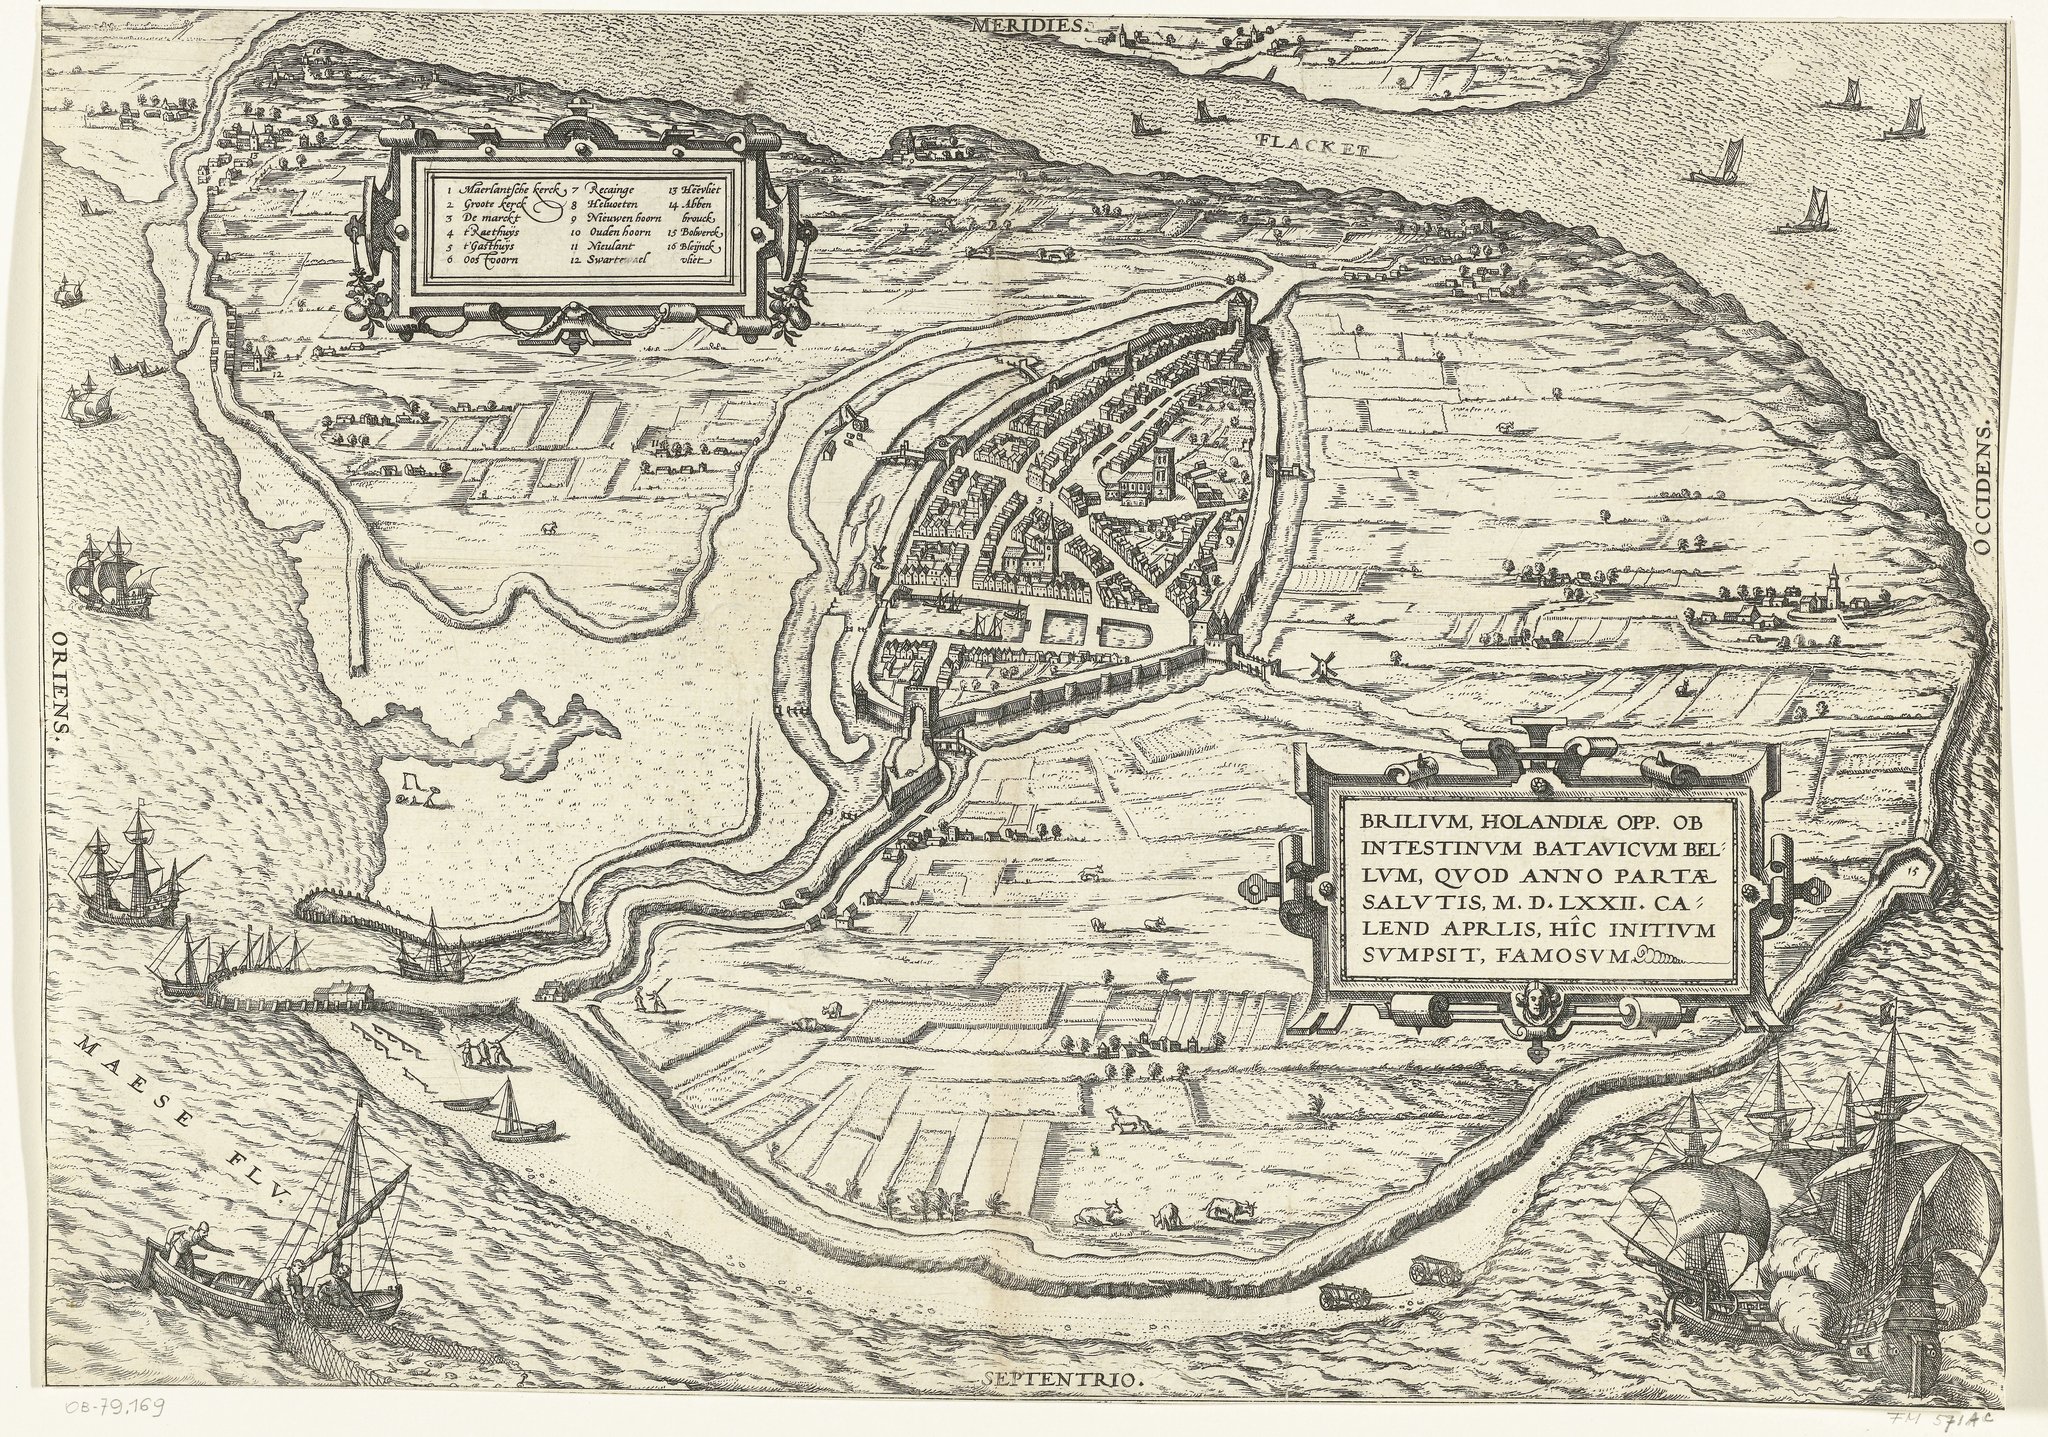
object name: print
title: Brilium, Holandiae opp. ob intestinum batavicum bellum, quod anno partae salutis M.D.LXXII. calend aprilis, hîc initium sumpsit, famosum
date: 1575-1657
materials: paper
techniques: etching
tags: maps of separate countries or regions, maps of cities, brielle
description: Deze (eerste) staat van prent voor het eerst ook gebruikt in: Braun, Georg en Frans Hogenberg. Civitates orbis terrarum. Dl. 2 / De praecipuis totius universi urbibus, liber secundus. Keulen: Gottfried von Kempen, 1575. Deze staat komt ook voor in de daaropvolgende uitgaven van 'Civitates orbis terrarum' en in de Duitse en Franse uitgaven, maar telkens met tekst op verso. Tweede staat van prent gebruikt in: Theatrum Urbium Celebriorum totius Belgii sive Germaniae Inferioris. 2 delen. Amsterdam: Johannes Janssonius, 1657, dl. 2.